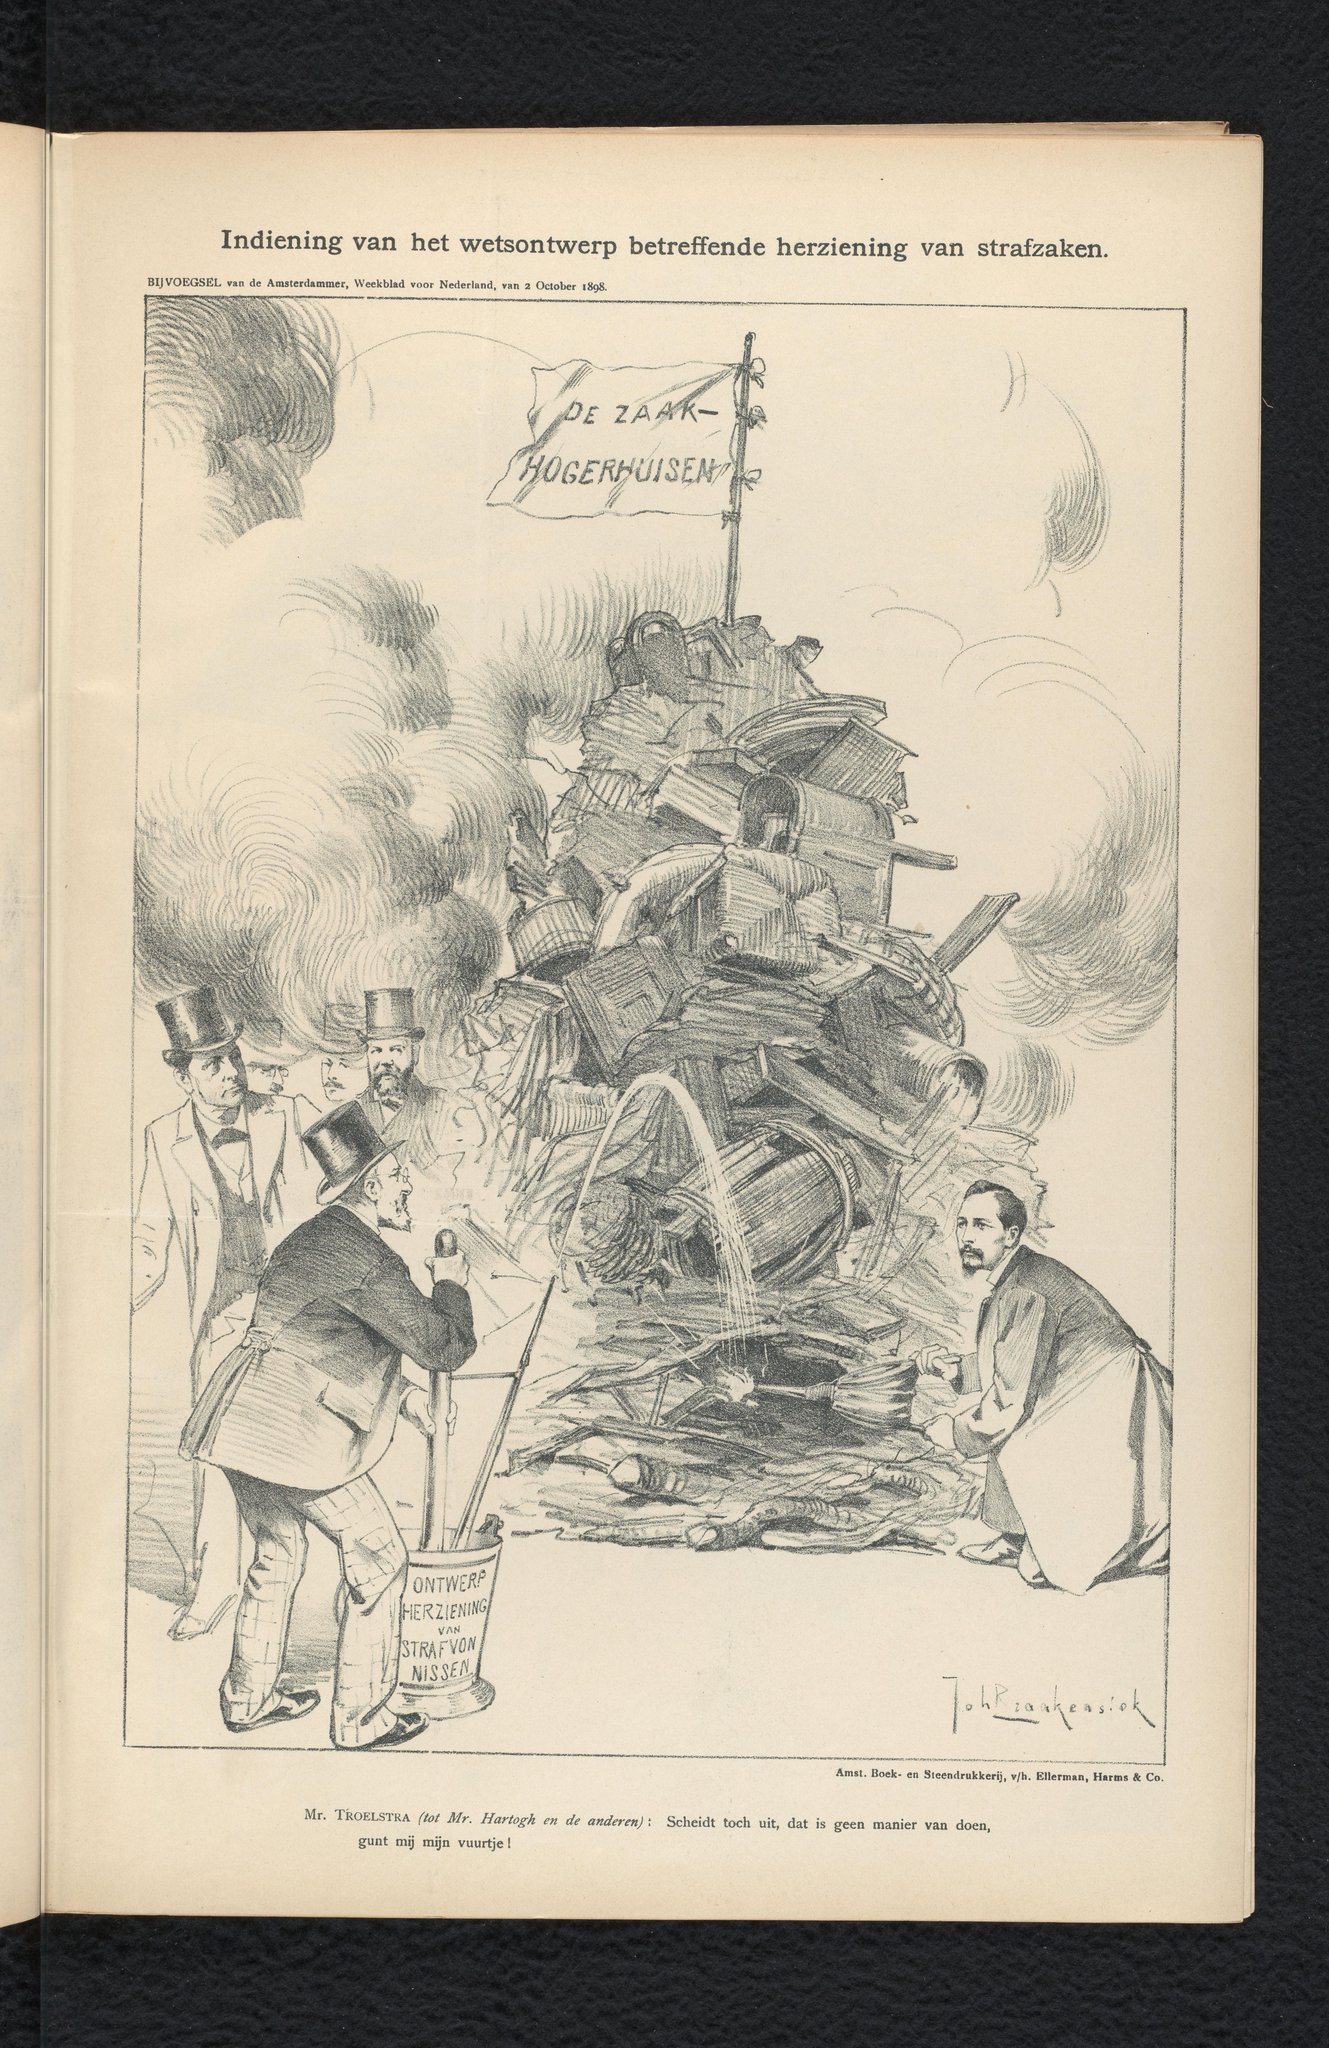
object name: cartoon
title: Indiening van het wetsontwerp betreffende herziening van strafzaken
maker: johan braakensiek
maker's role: draughtsman, print maker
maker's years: 1858-1940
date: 1898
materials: paper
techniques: lithograph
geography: netherlands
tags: politician, administration of justice, trial, burning, pump (fire-extinguishing equipment), political caricatures and satires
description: Troelstra wil een grote brandstapel aansteken, maar Hartogh blust meteen de eerste vlammen. In verband met de herziening van de strafzaak Hogerhuisen.